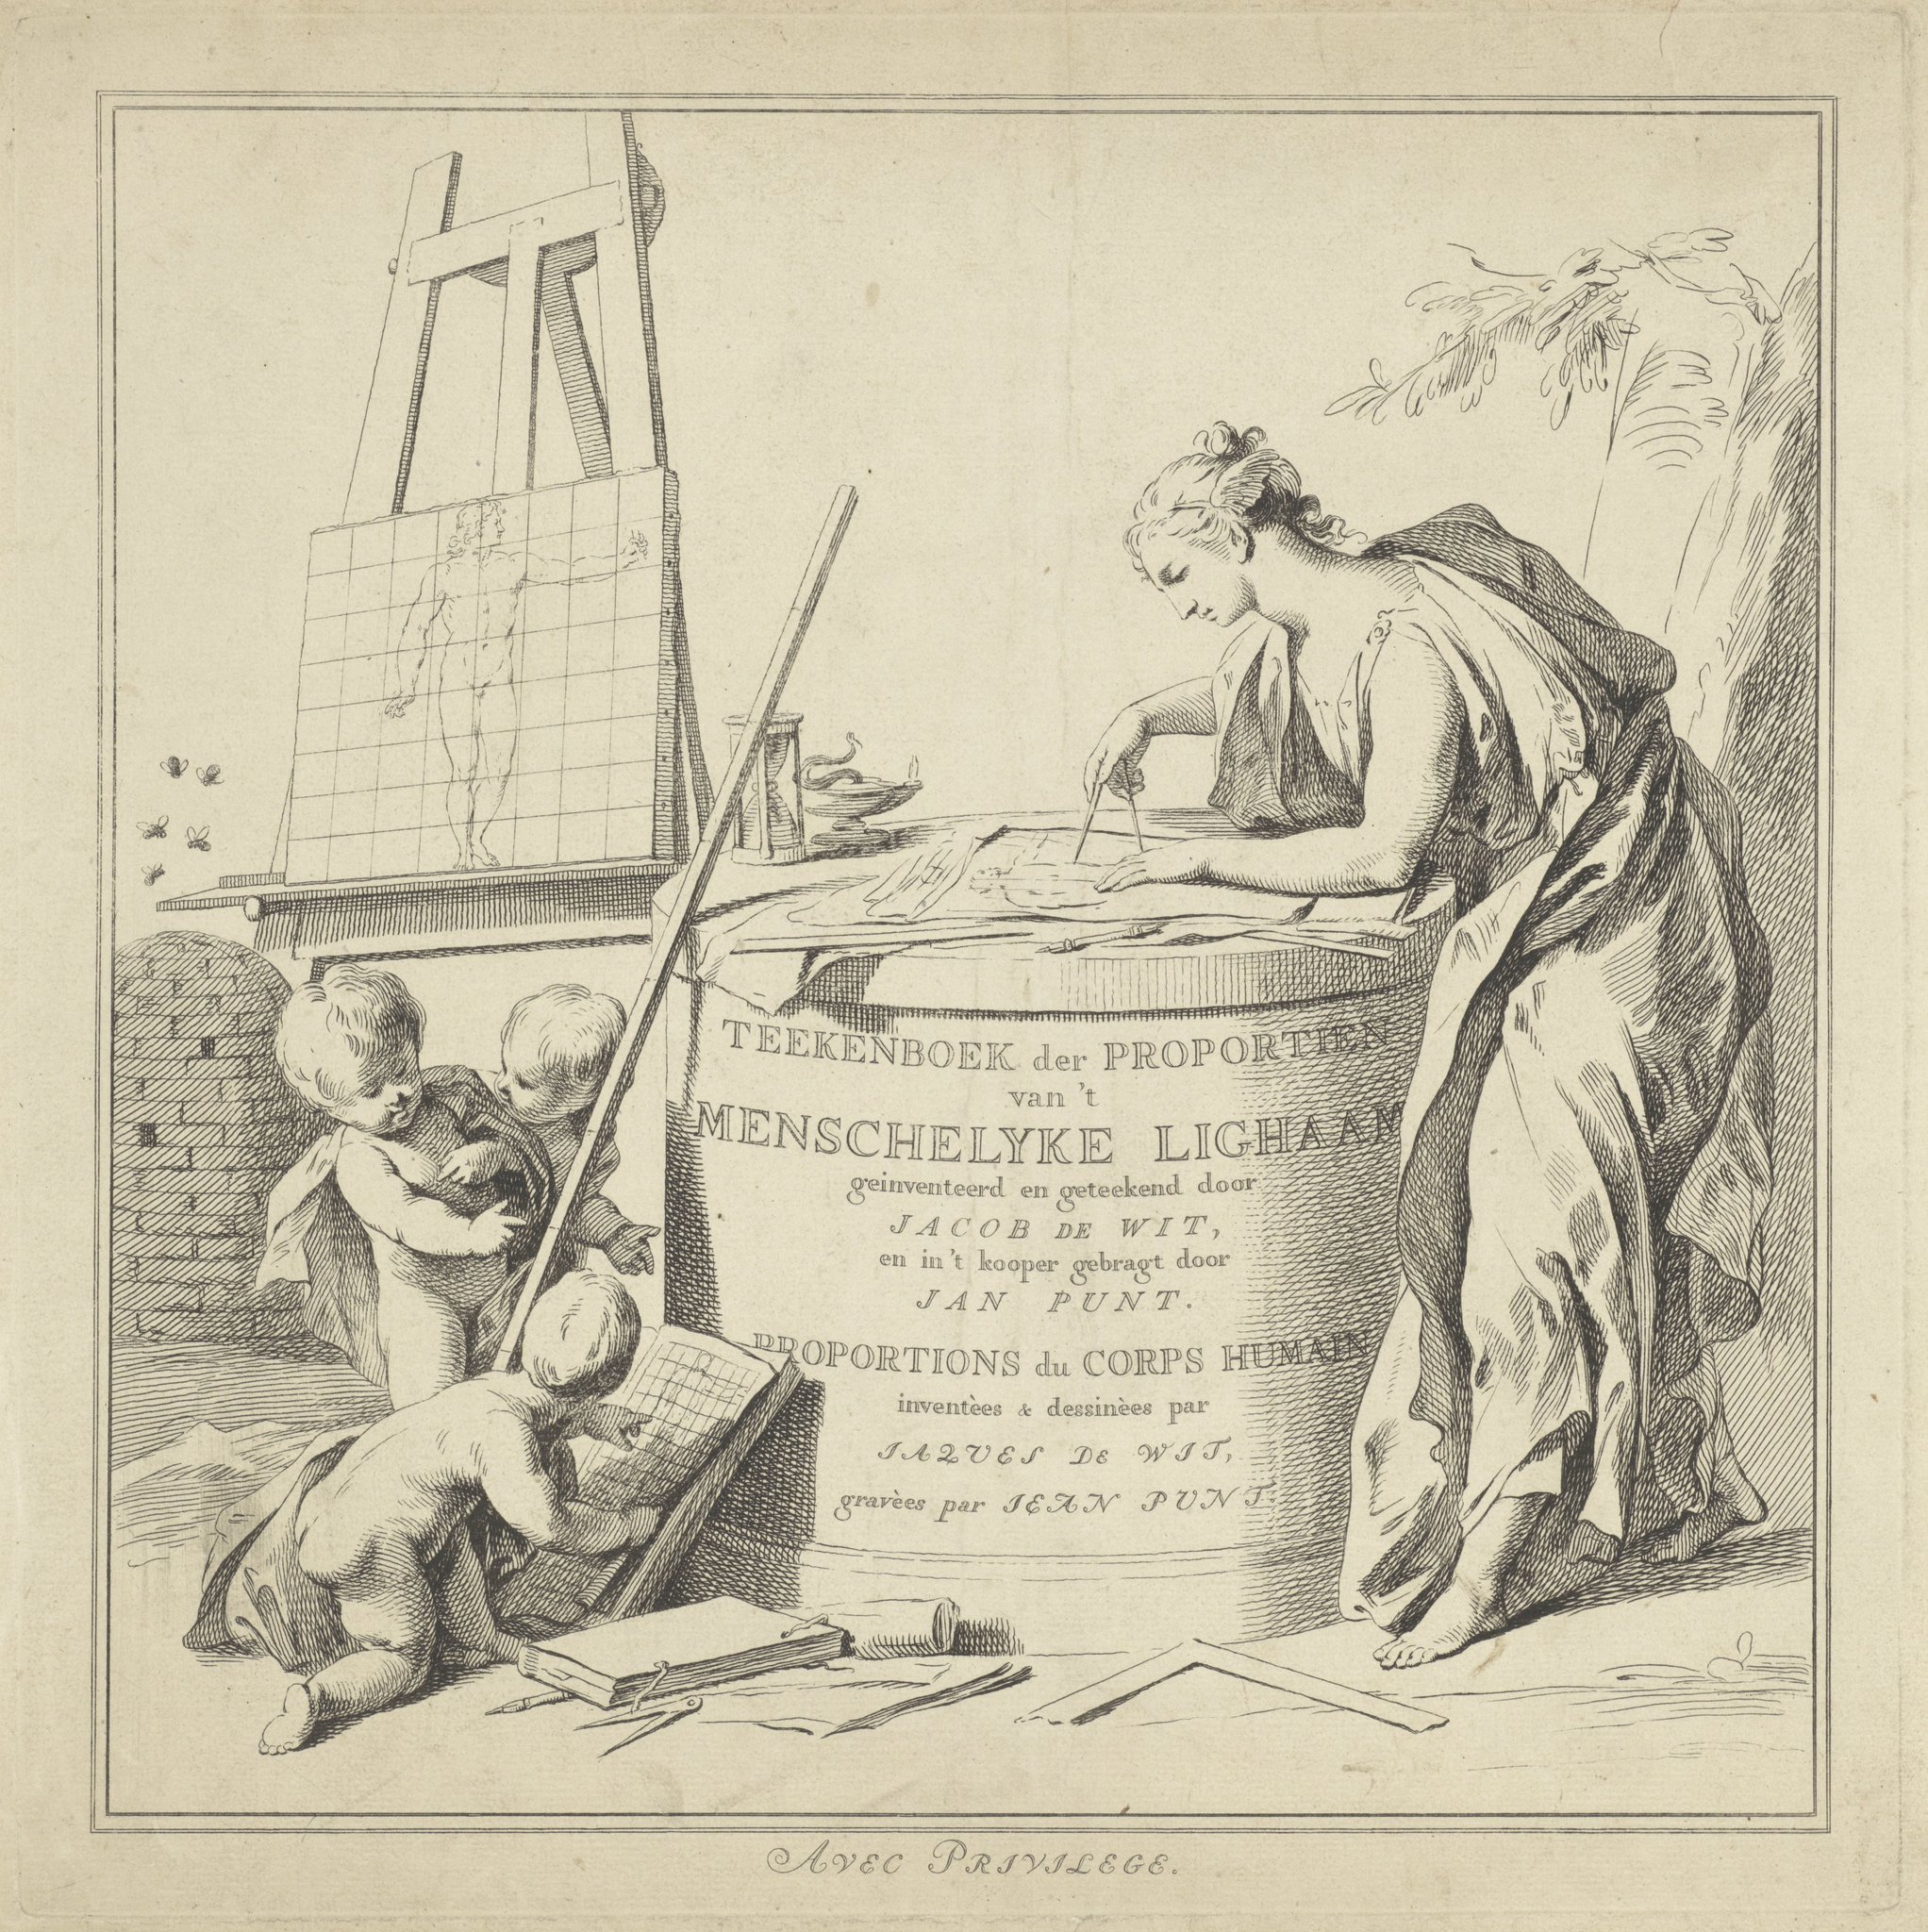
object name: print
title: Tekenkunst maakt een anatomische studie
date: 1747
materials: paper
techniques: etching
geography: amsterdam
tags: some aspects of anatomy in particular, hourglass, bee-hive, easel, symbolic representations, allegories and emblems ~ drawing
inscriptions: collector's mark: Lugt 2228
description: Tekenkunst maakt op een vel papier een anatomische studie van een man. Voor haar staan een zandloper en olielamp. Drie putti bestuderen een boek op de voorgrond. Links een bijenkorf en een ezel met een anatomische studie. Op het basement de titel in het Nederlands en in het Frans.